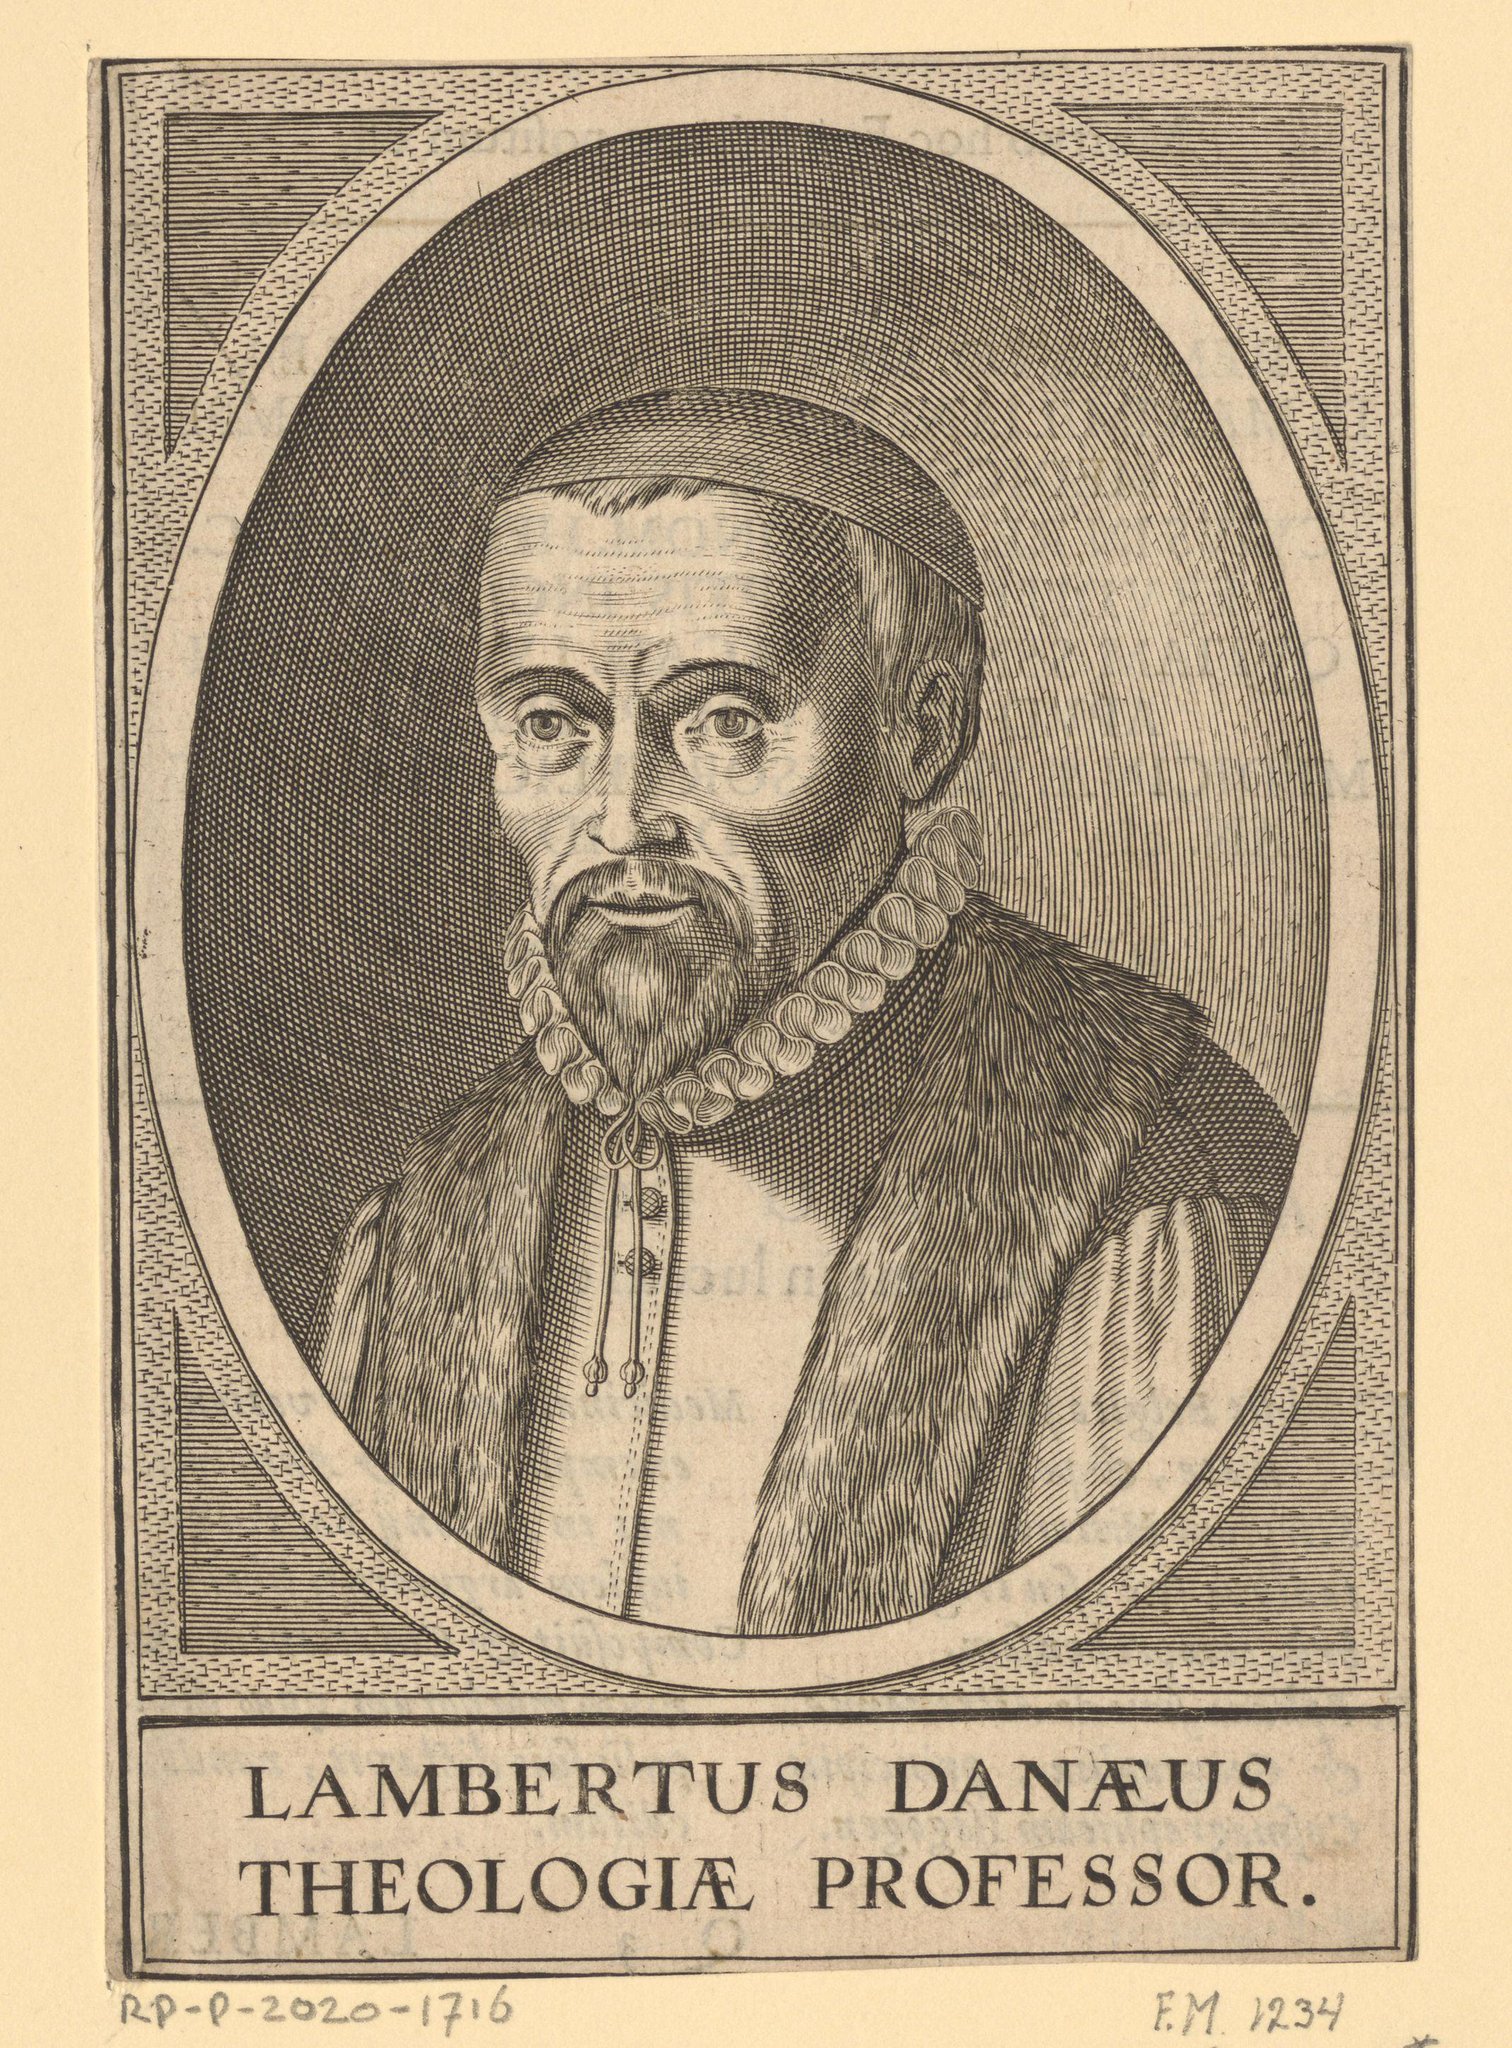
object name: print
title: Portret van Lambert Daneau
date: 1625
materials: paper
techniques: engraving, letterpress printing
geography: leiden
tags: theologian, historical persons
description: Prent uit: Meursius, Joannes. Athenae Batavae. Sive, de urbe Leidensi & academia, virisuw claris (...). Leiden: Andries Clouck en Bonaventura en Abraham Elzevier, 1625, p. 126. Prent voor het eerst verschenen in: Meursius, Joannes. Icones ad vivum delineatae et expressae. Leiden: Andries Clouck, 1609. En later met tekst op verso in: Meursius, Joannes. Illustris academia Lugd-Batava (...). Leiden: Andries Clouck, 1613. En in: Meursius, Joannes. Icones, elogia ac vitae professorum Lugdunensium apud Batavos (...). Leiden: Andries Clouck, 1617.